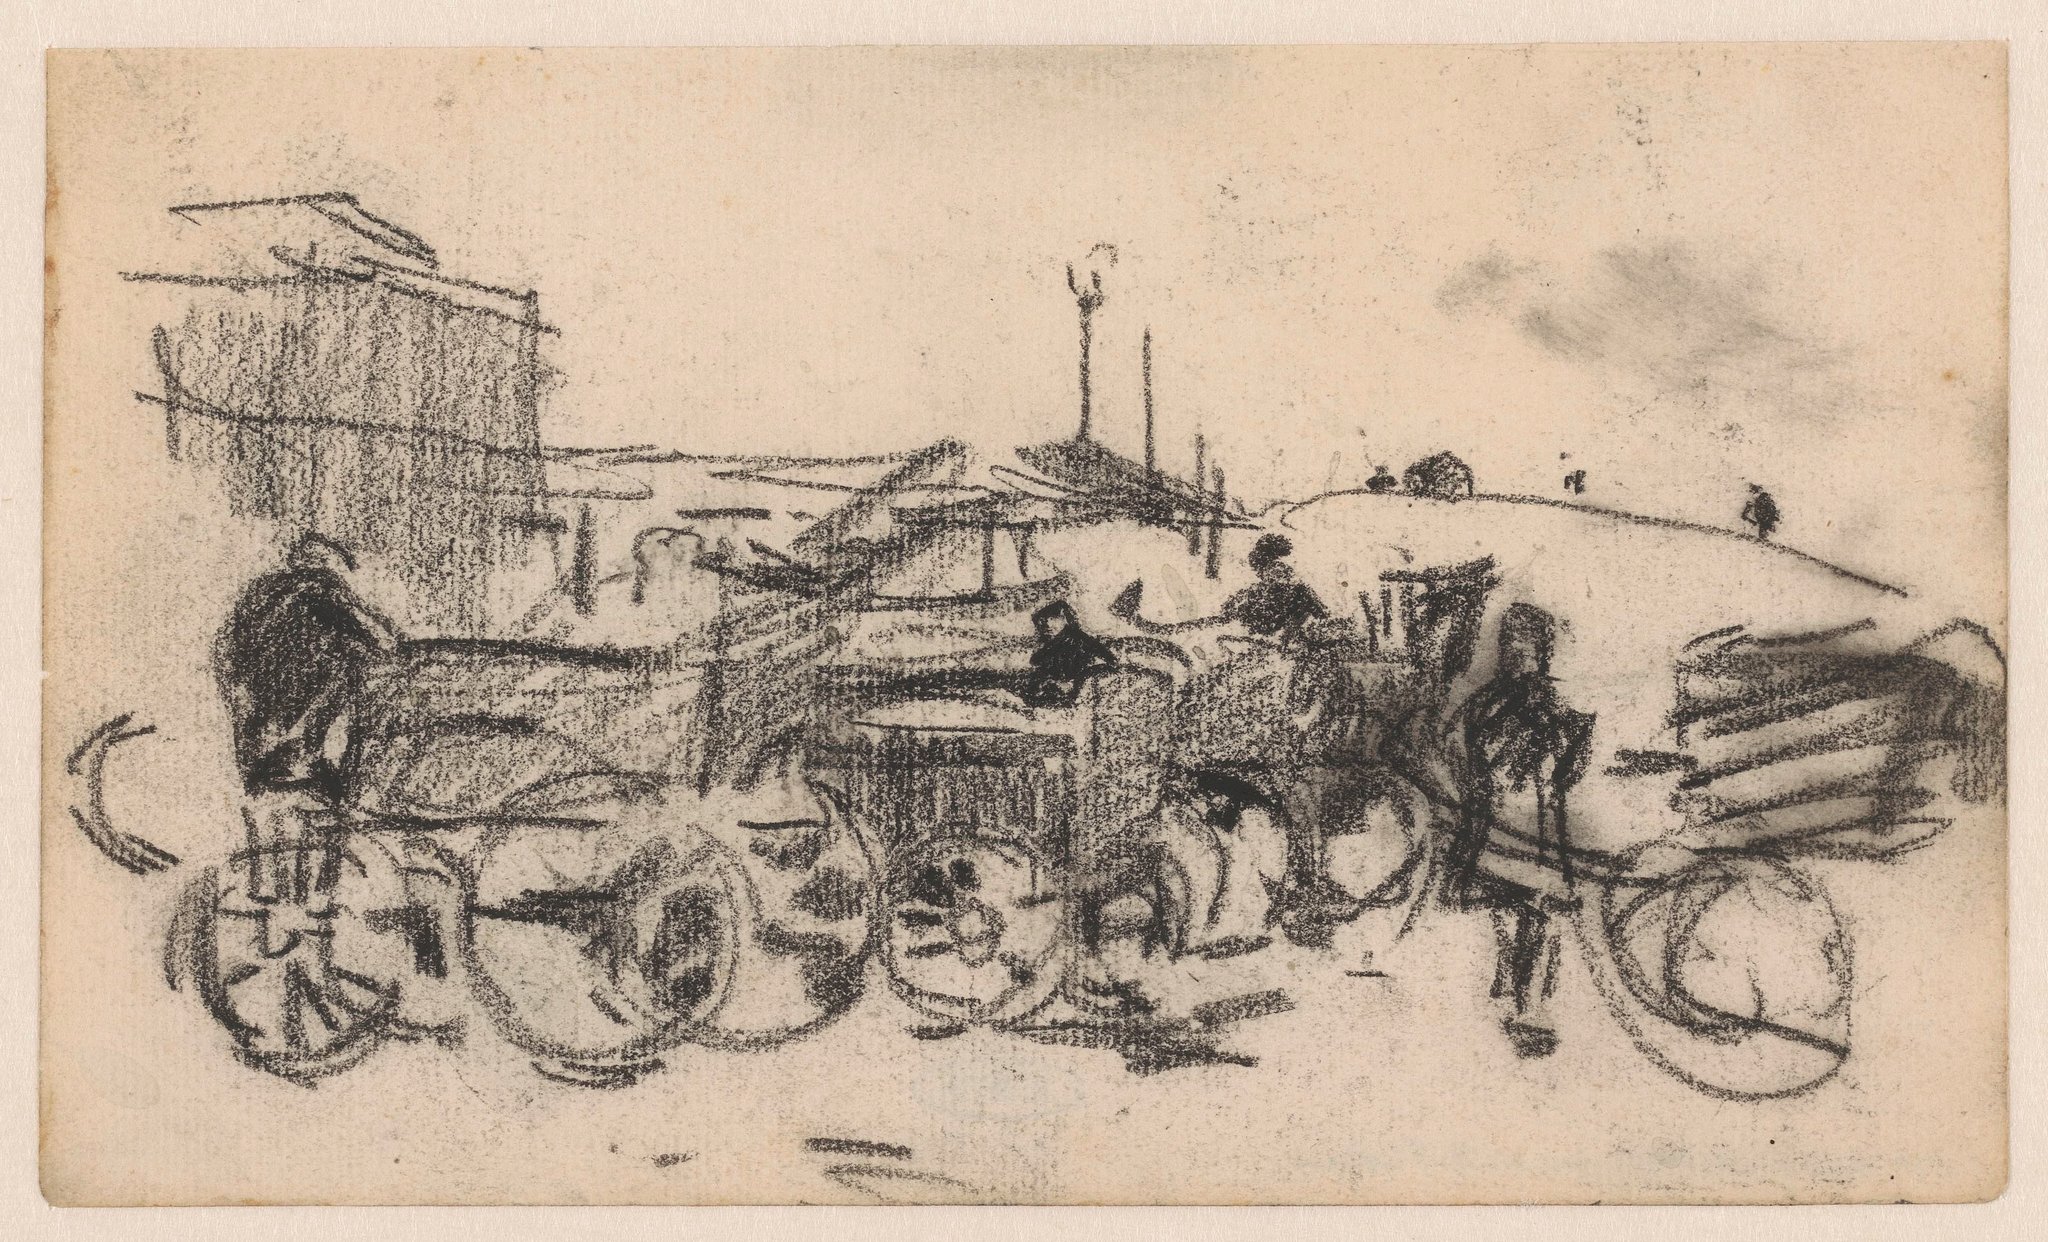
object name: drawing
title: Boeren met karren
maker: willem bastiaan tholen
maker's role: draughtsman, painter, print maker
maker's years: 1860-1931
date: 1870-1931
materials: chalk, paper